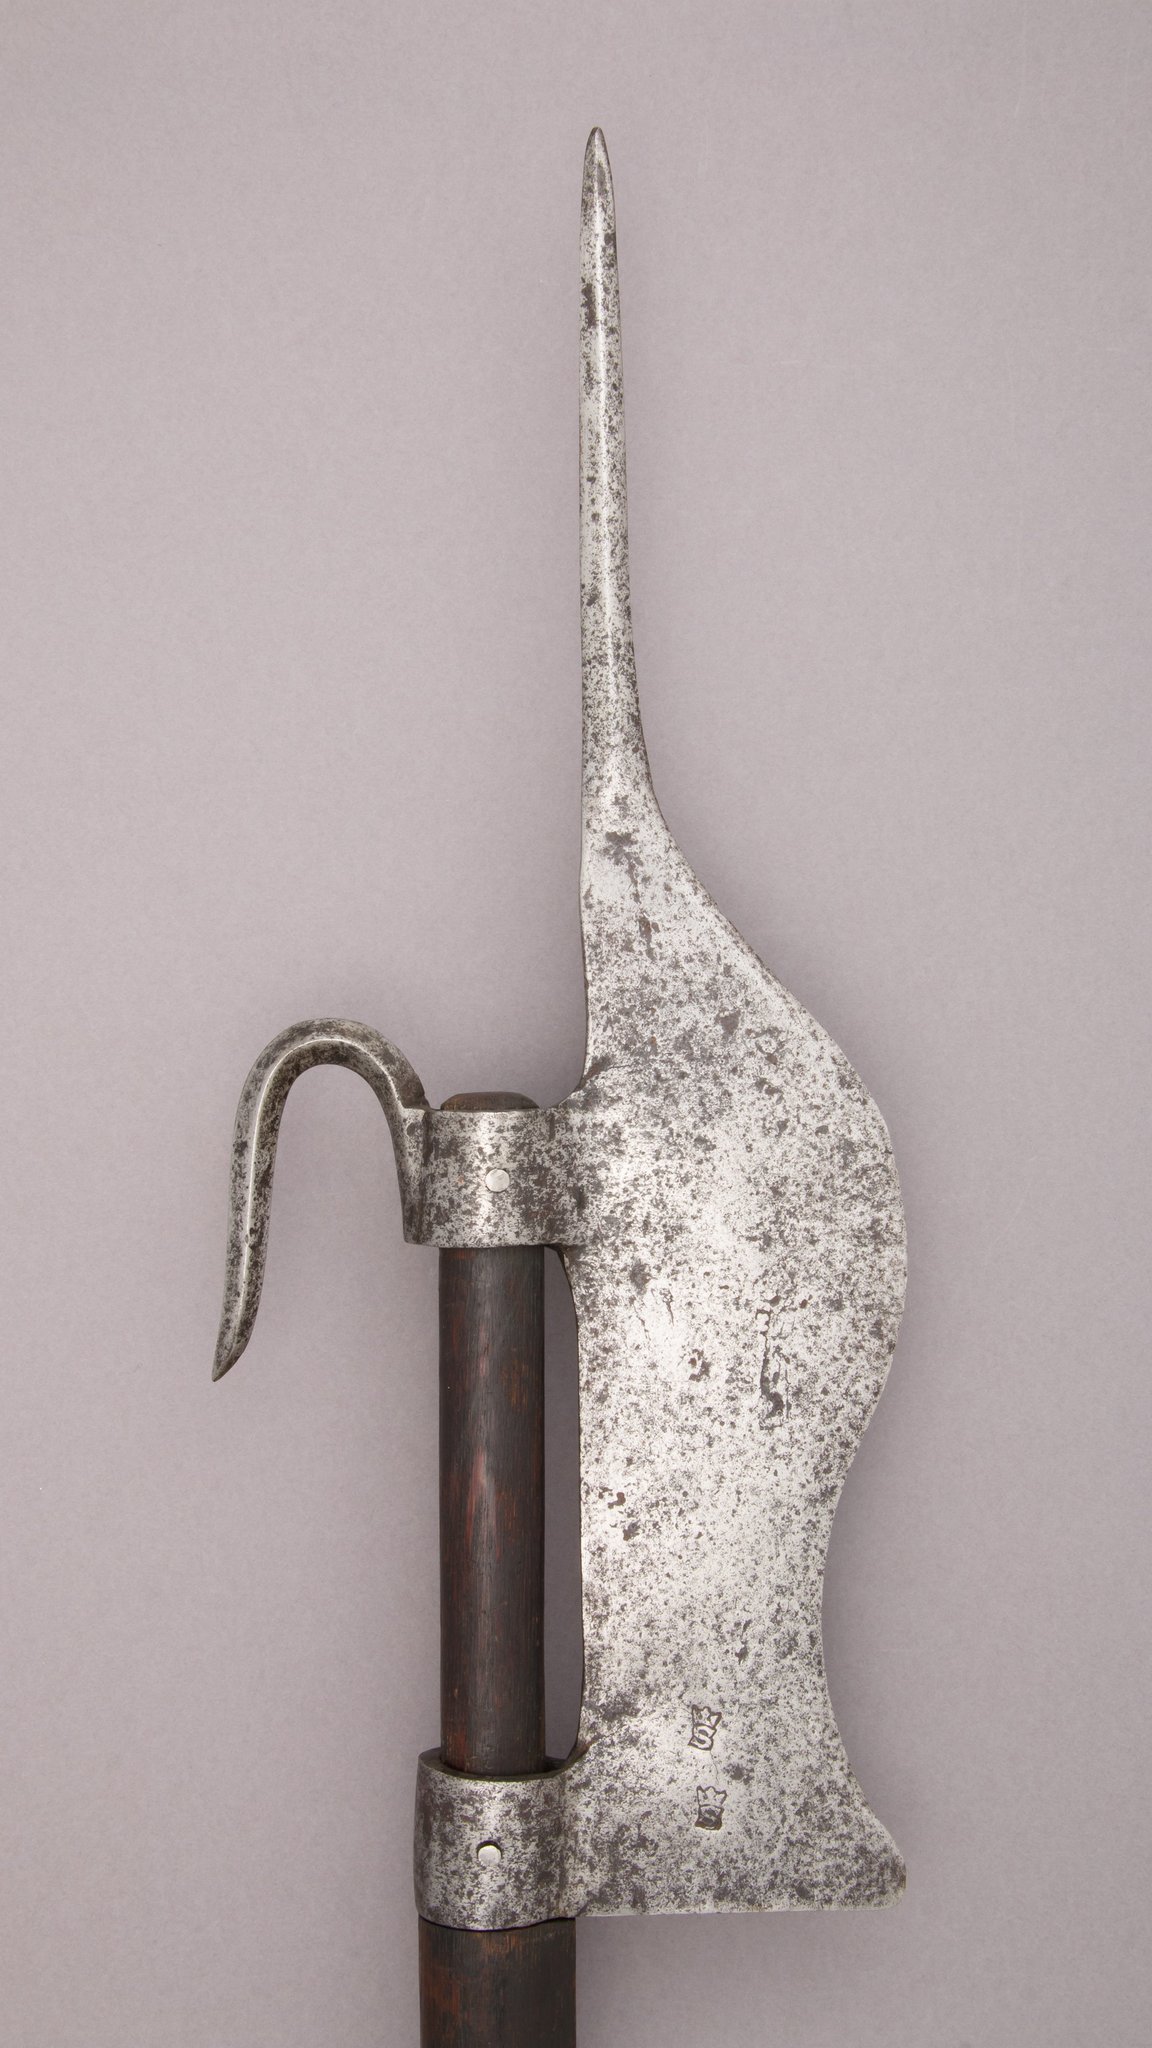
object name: staff weapon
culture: italian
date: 1401-1500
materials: steel, wood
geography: italy